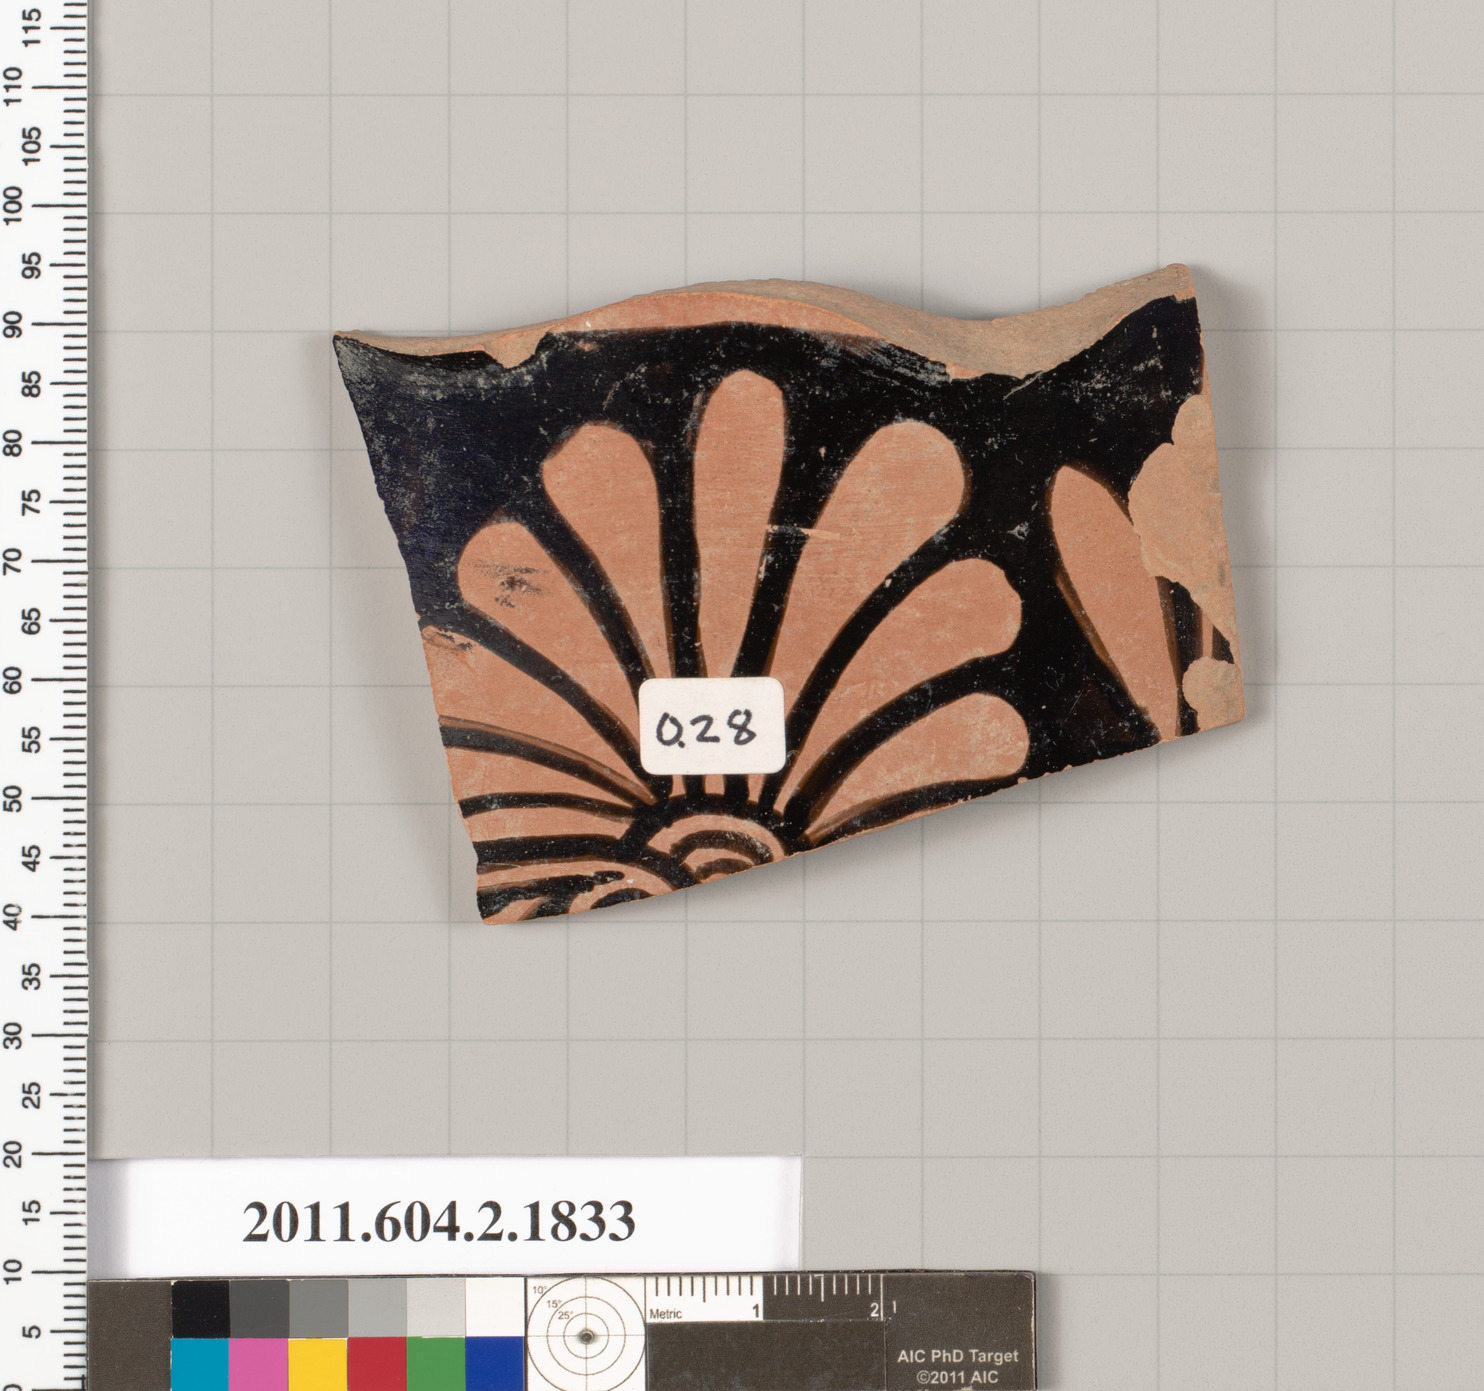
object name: skyphos fragment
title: Terracotta fragment of a skyphos (deep drinking cup)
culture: greek, attic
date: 440-420 BCE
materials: terracotta